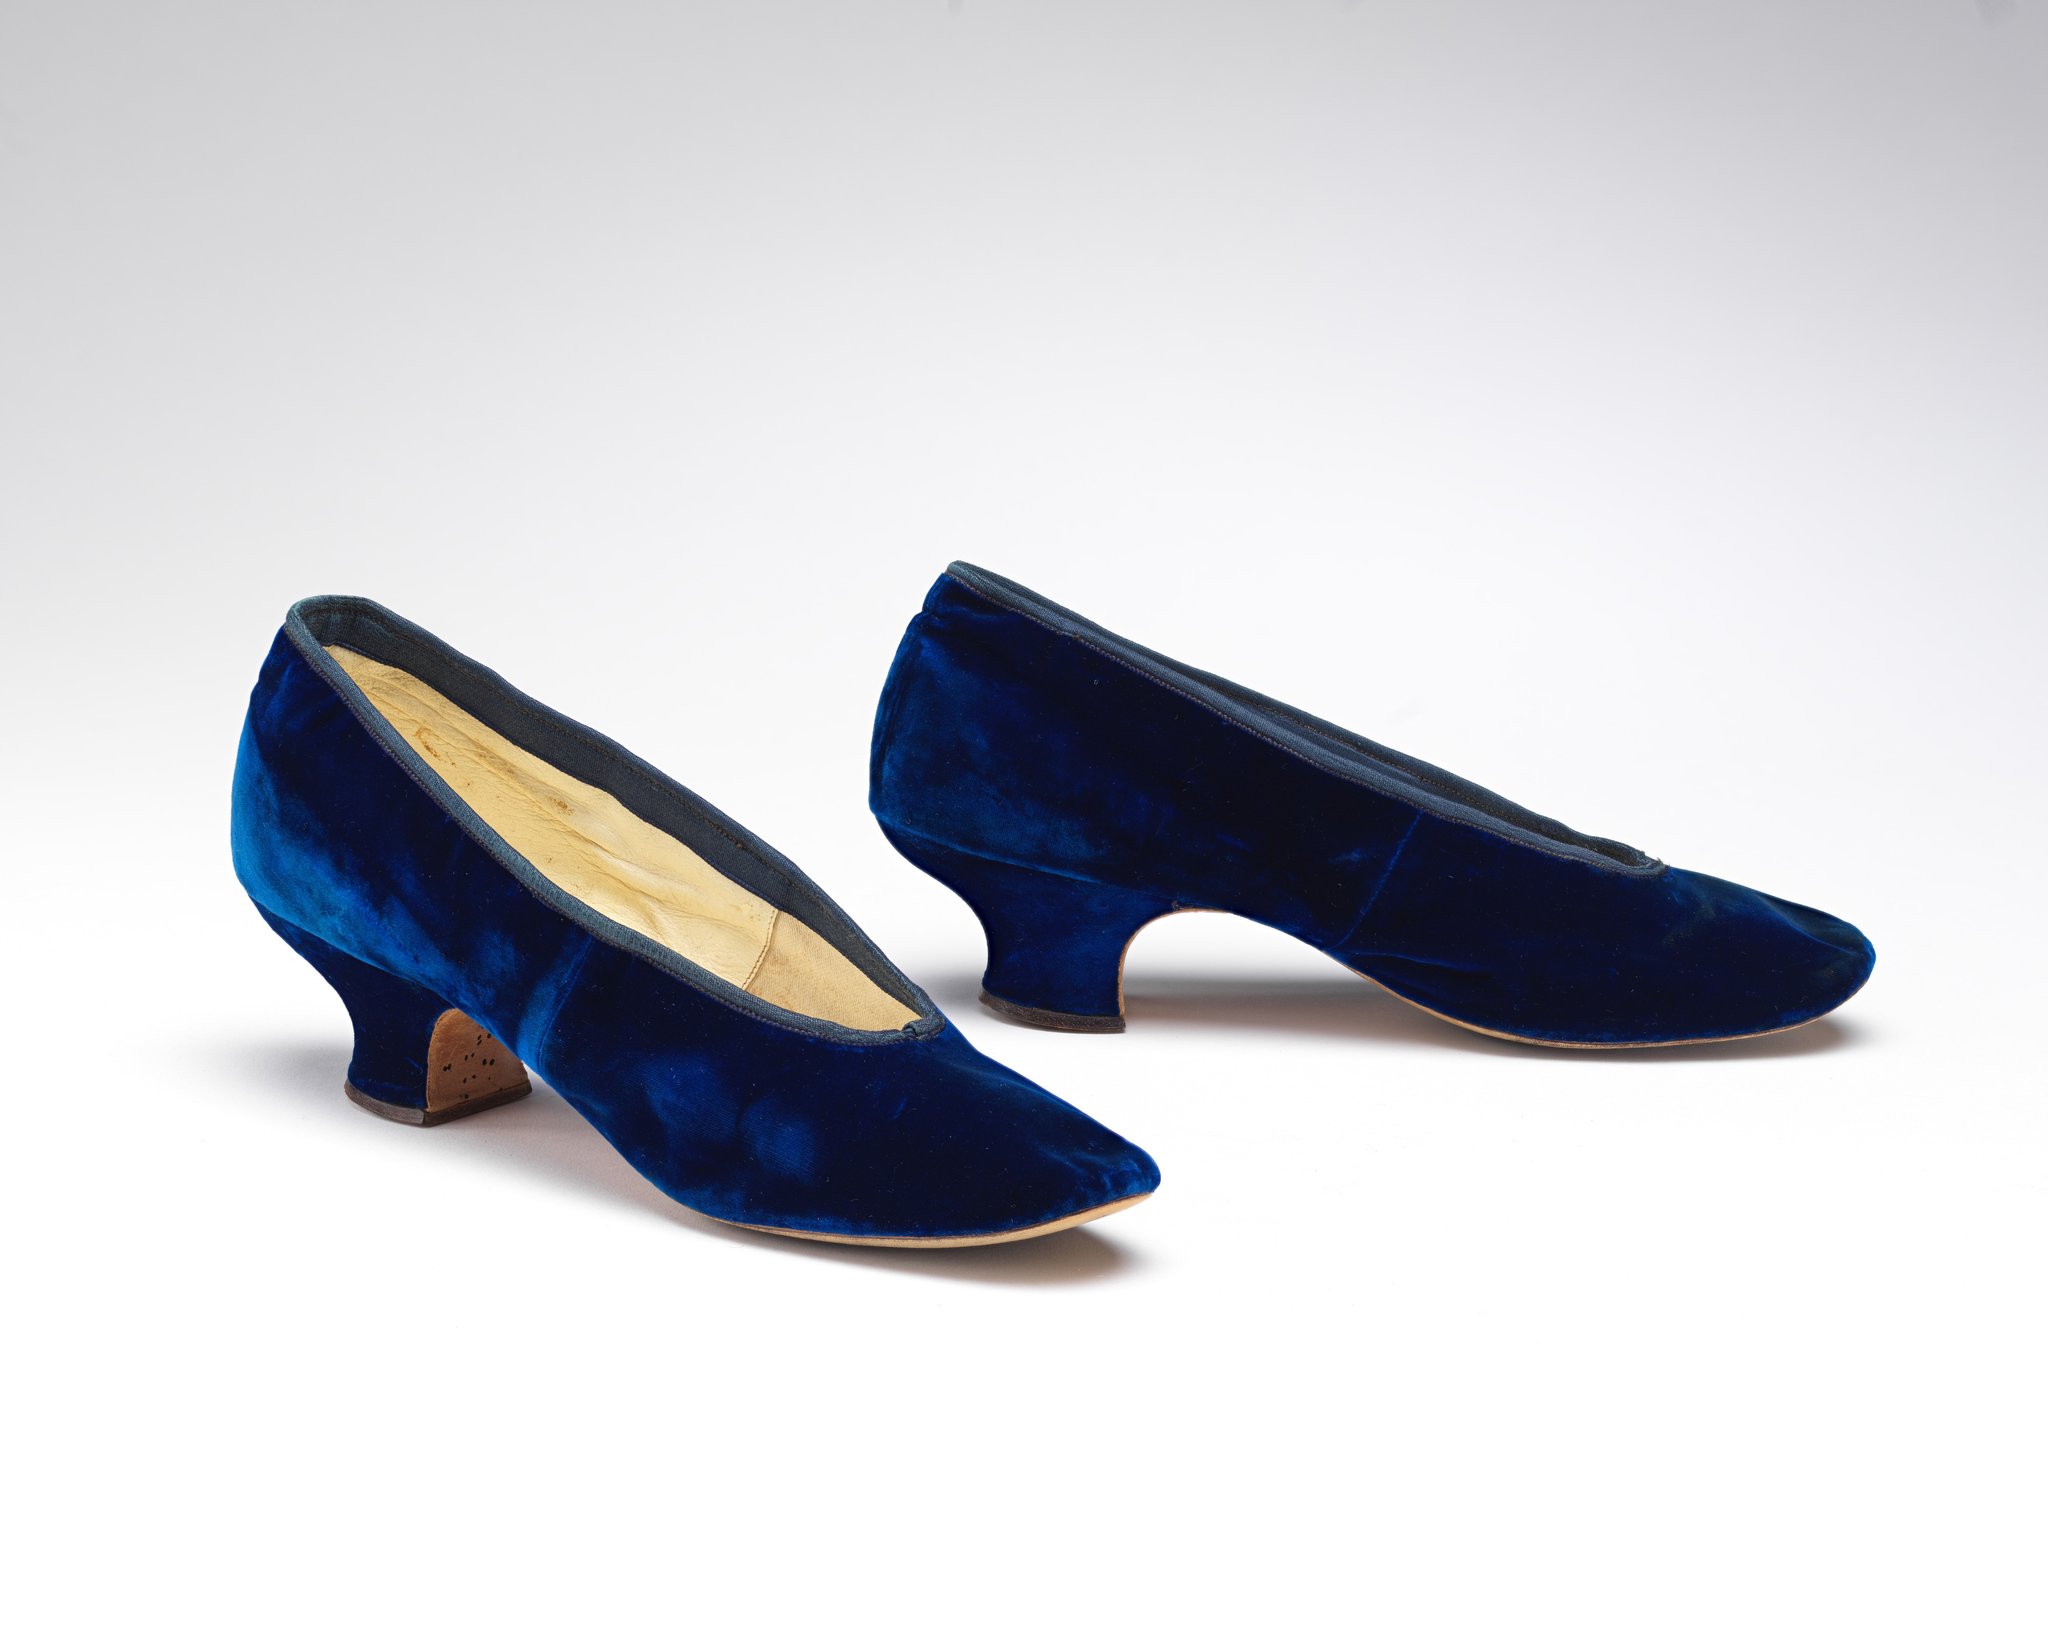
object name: evening slipper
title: Evening slippers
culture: american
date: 1885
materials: silk